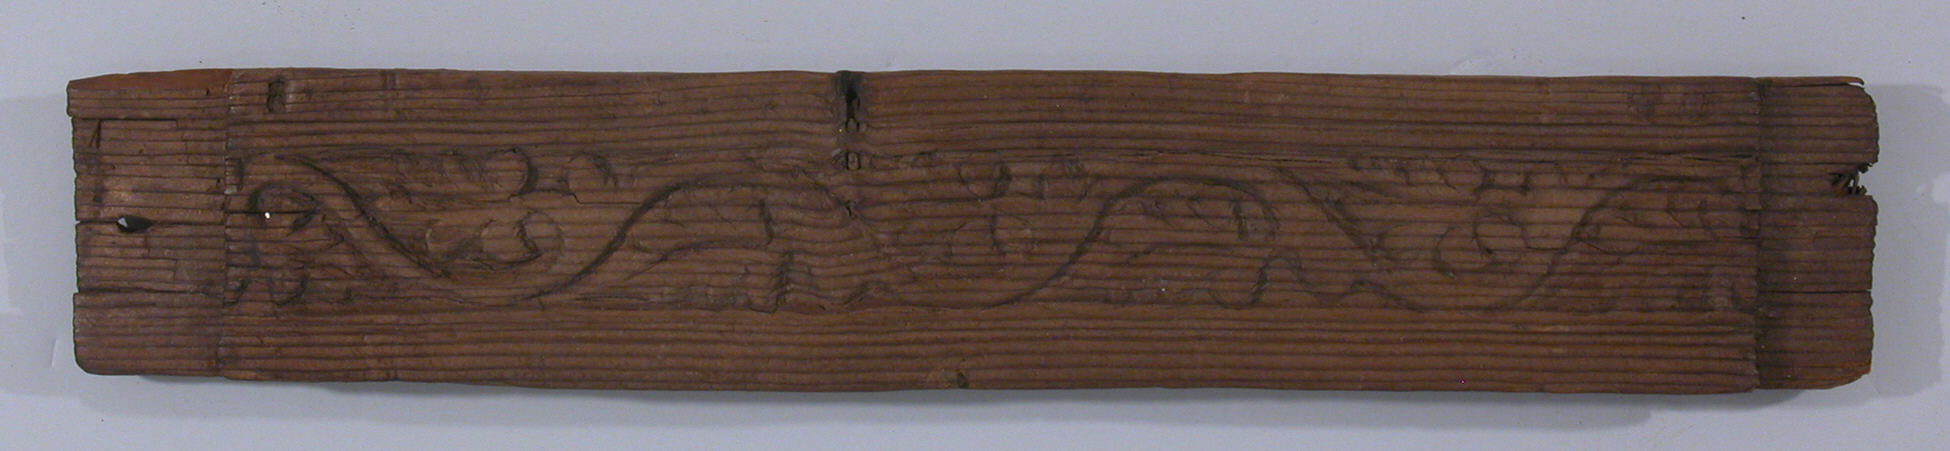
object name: panel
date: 601-800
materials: wood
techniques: carving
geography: egypt